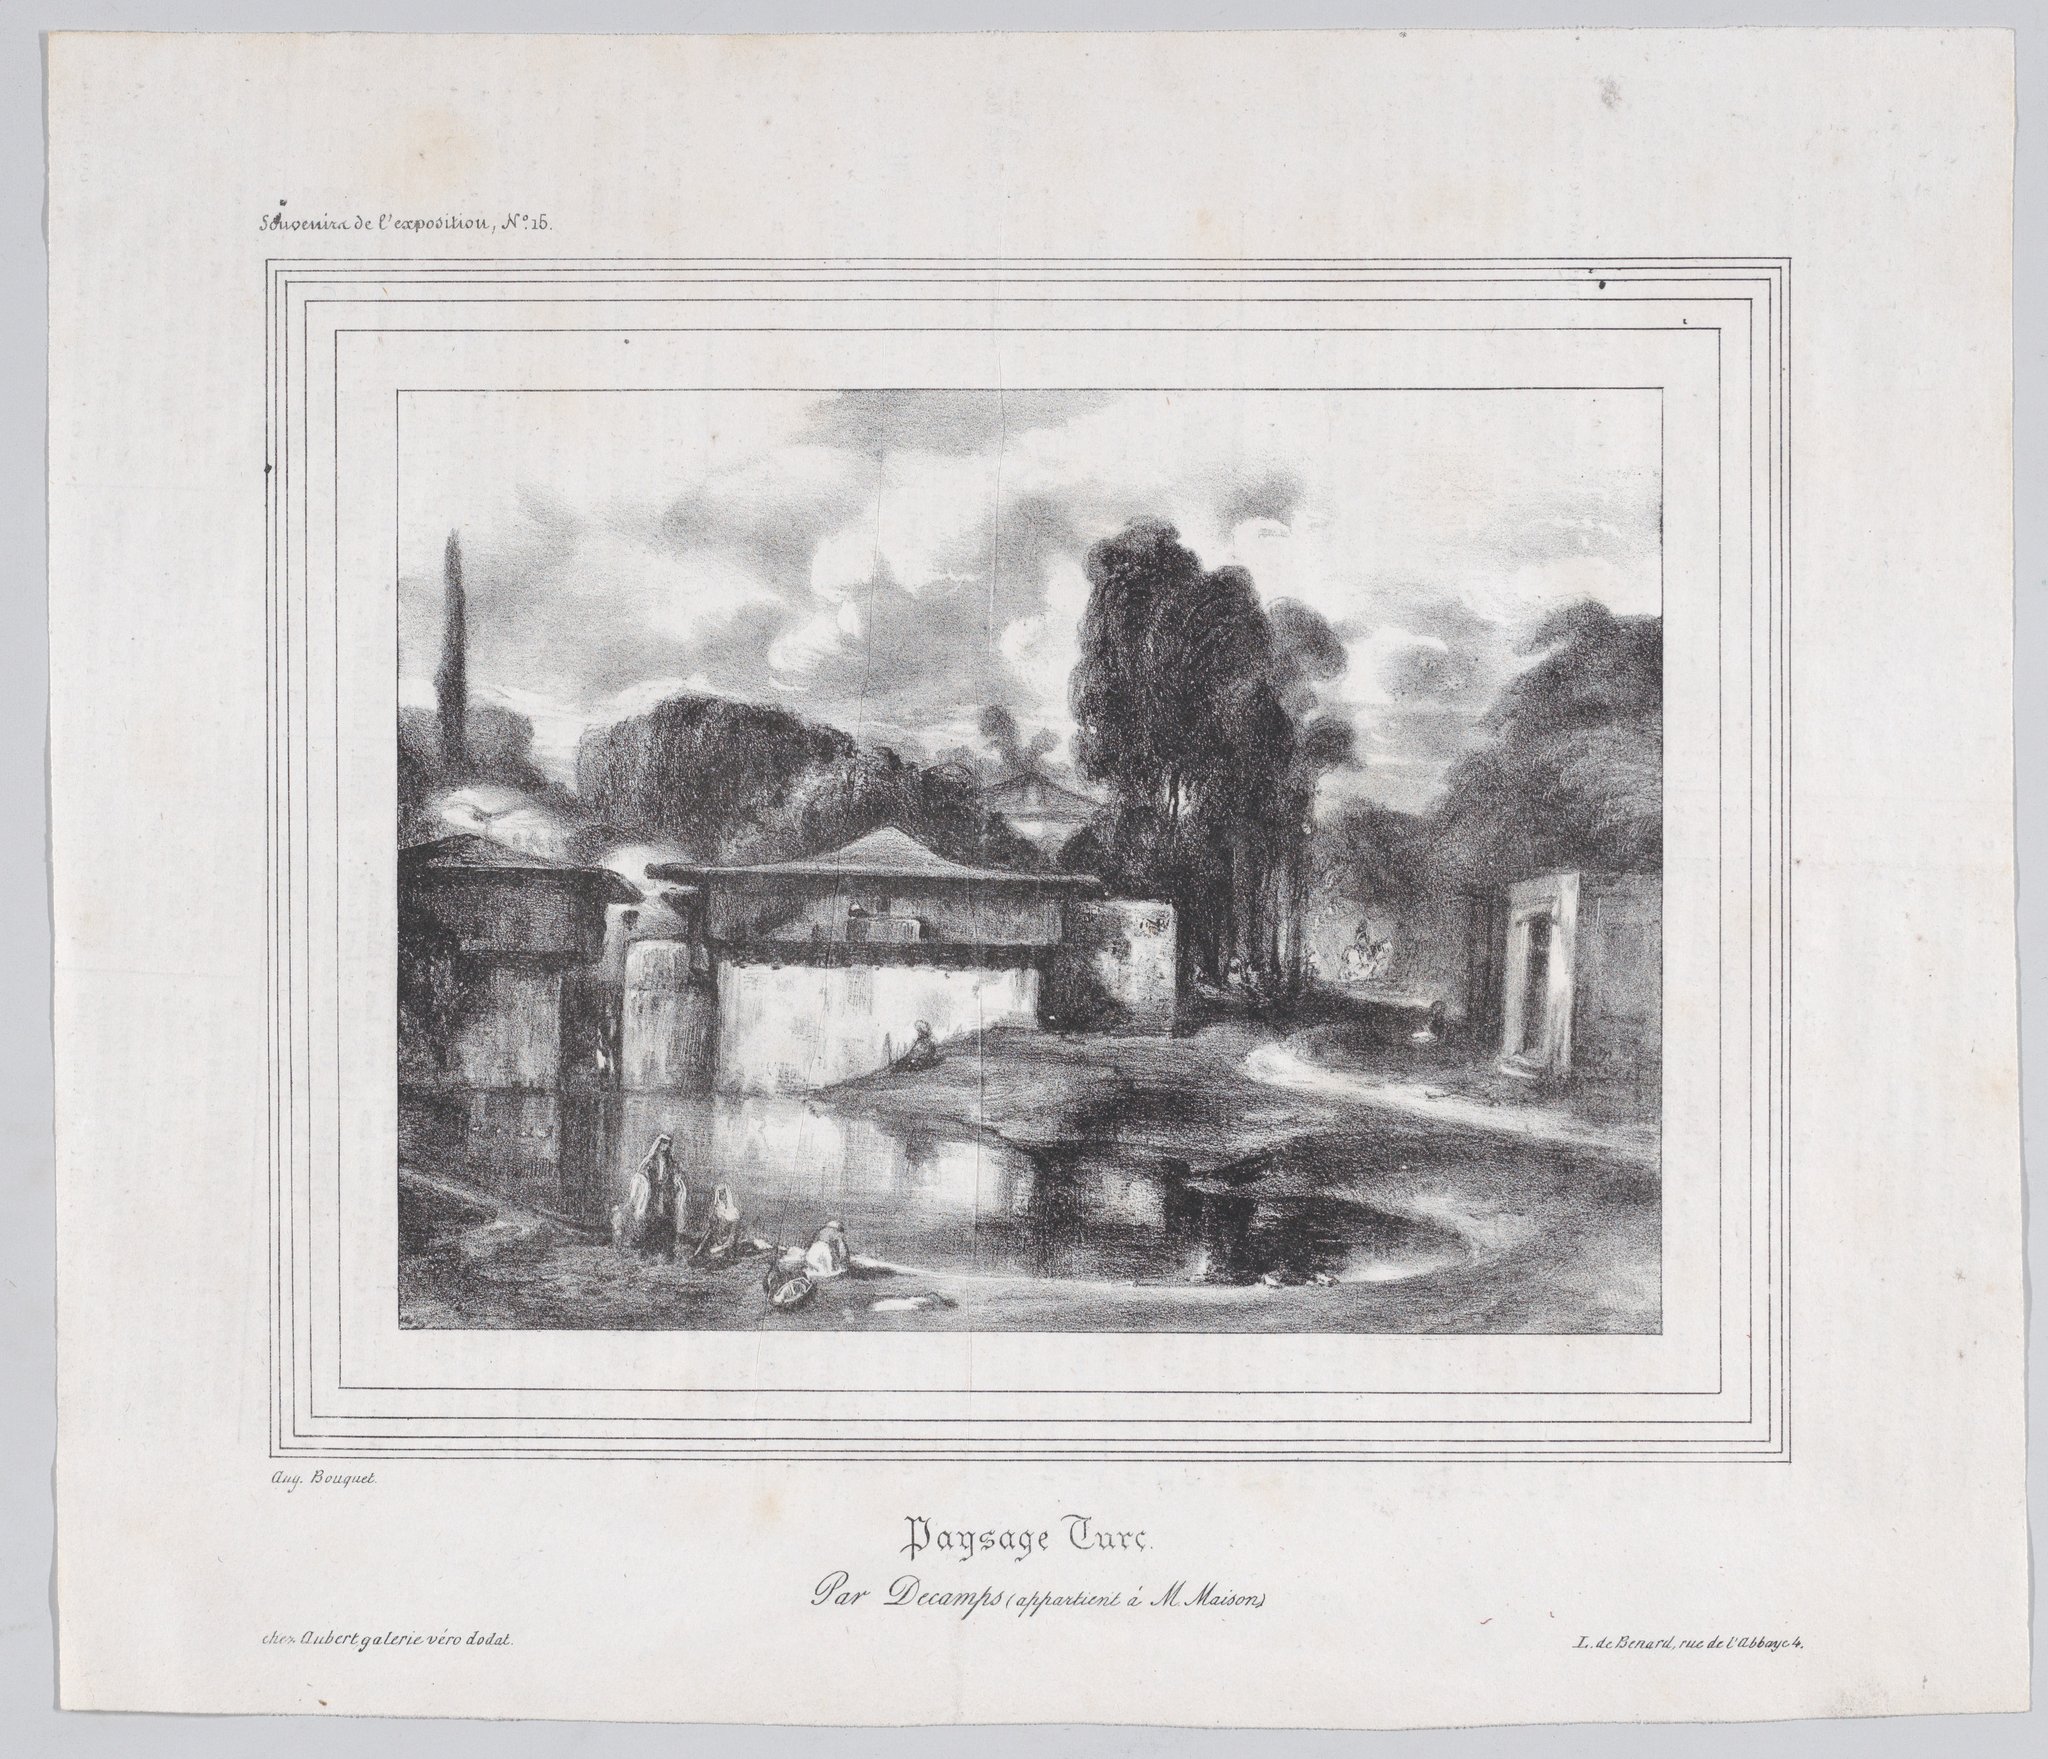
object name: print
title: Turkish Landscape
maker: alexandre-gabriel decamps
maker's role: artist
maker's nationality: french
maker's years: 1803-1860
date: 1823-1860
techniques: lithograph